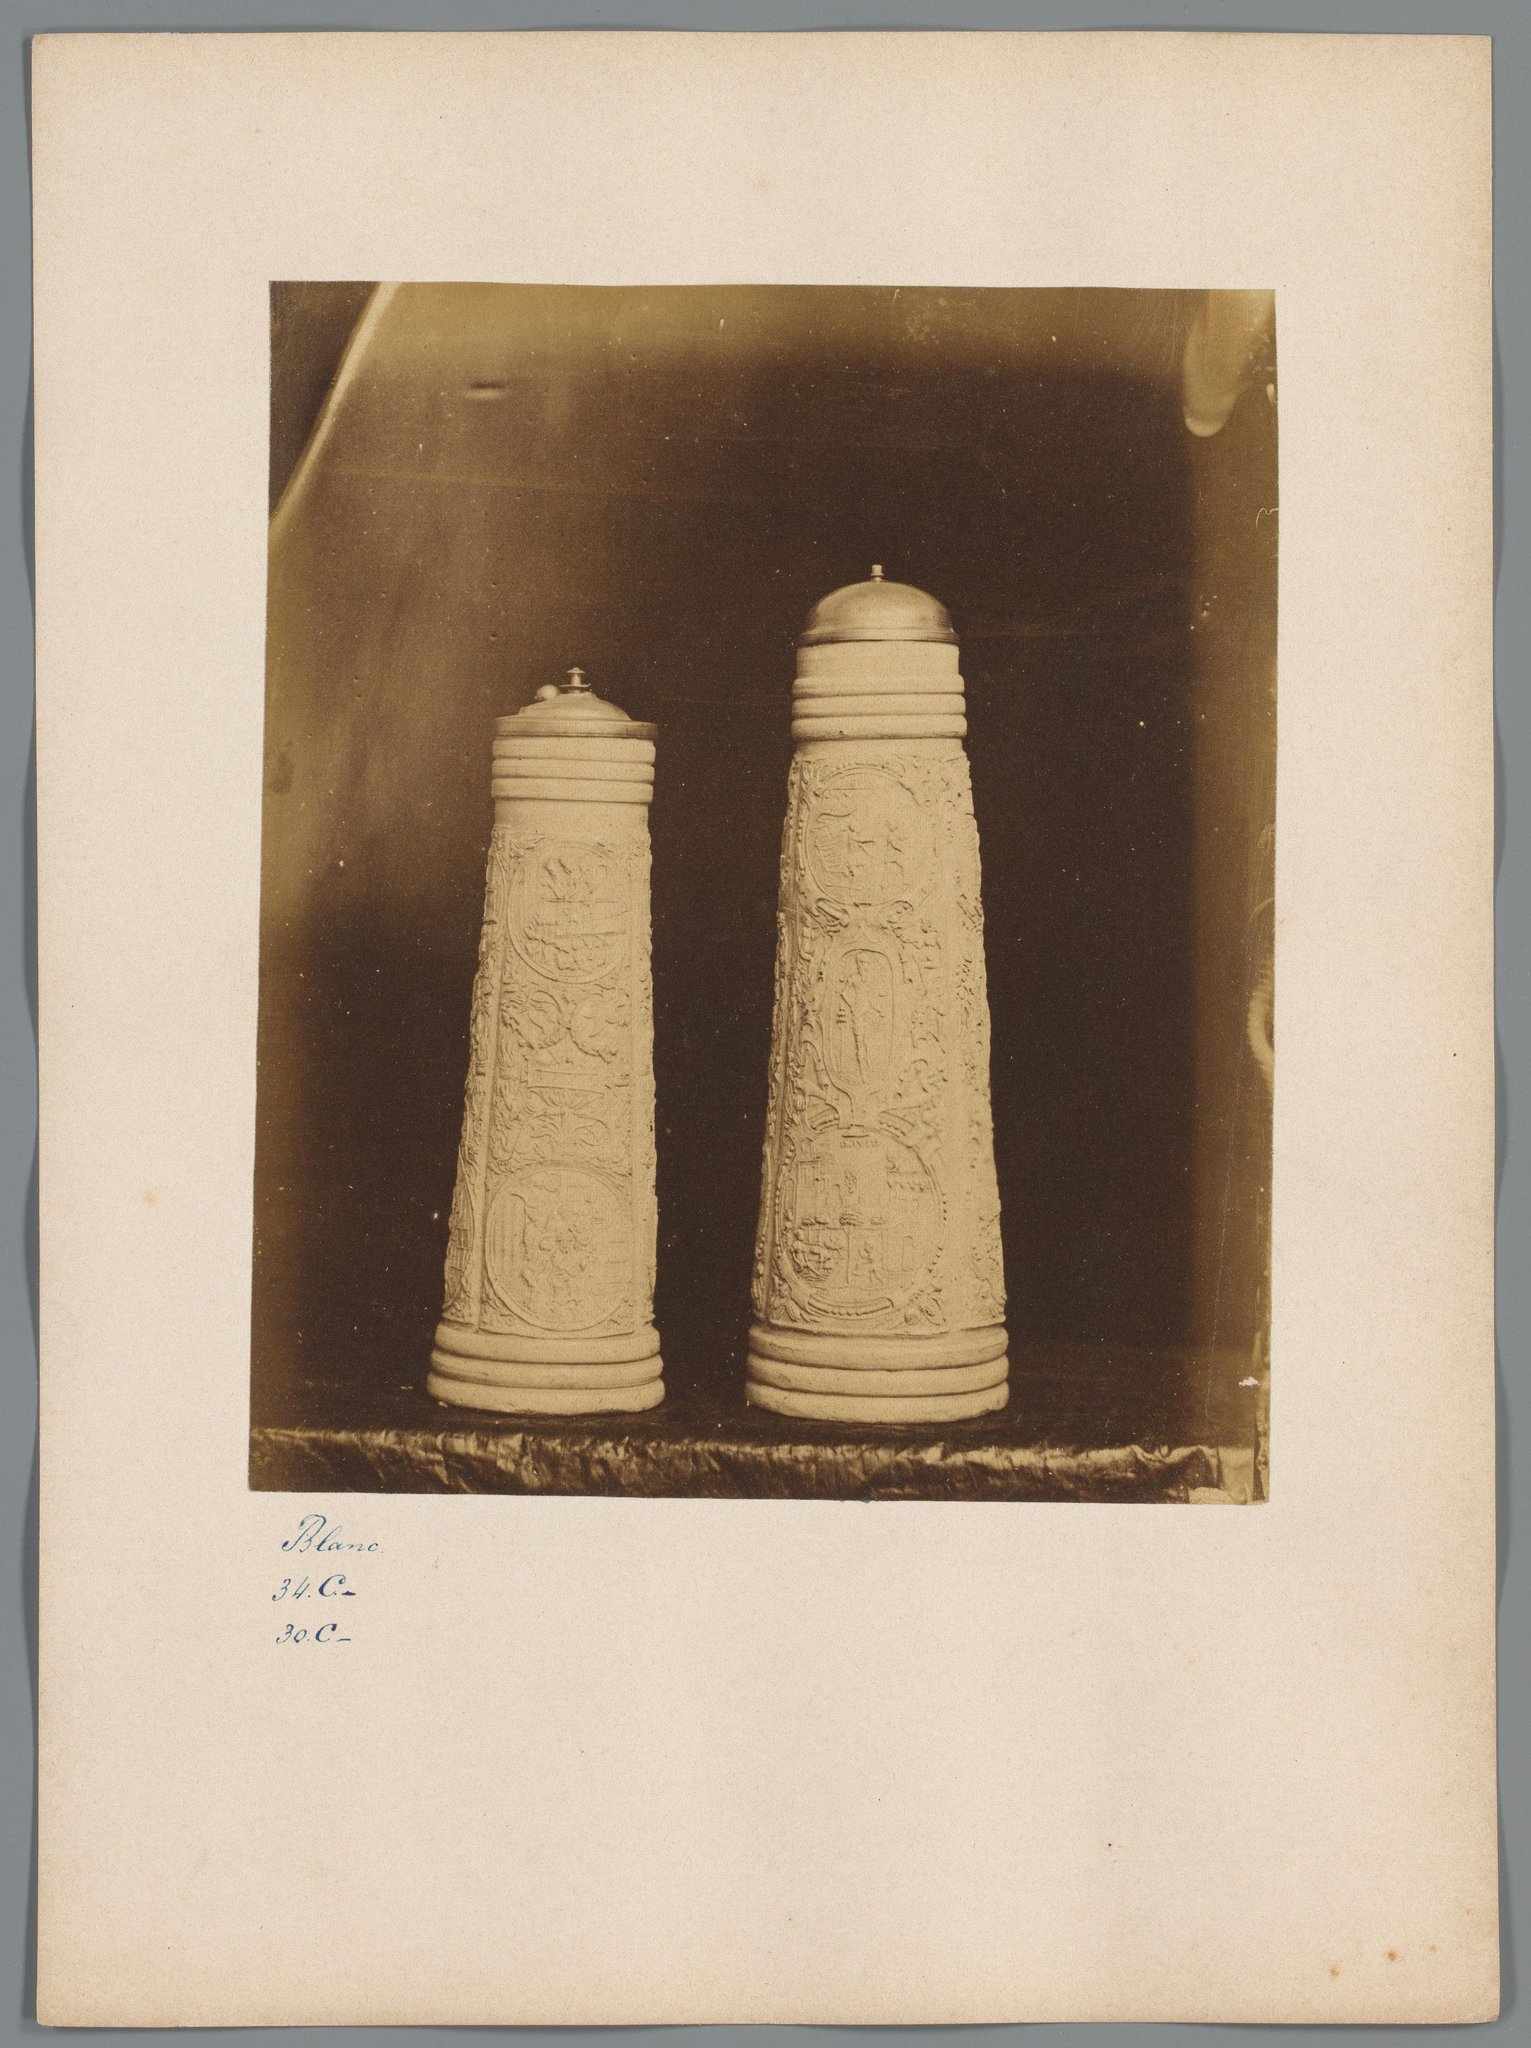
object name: photograph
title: Twee aardewerken vazen uit de collectie van W. de Weckherlin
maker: Anonymous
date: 1860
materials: paper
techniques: albumen print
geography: the hague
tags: container of ceramics: jar, jug, pot, vase, the hague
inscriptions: inscription: ‘Blanc./ 34.C./ 30.C.’